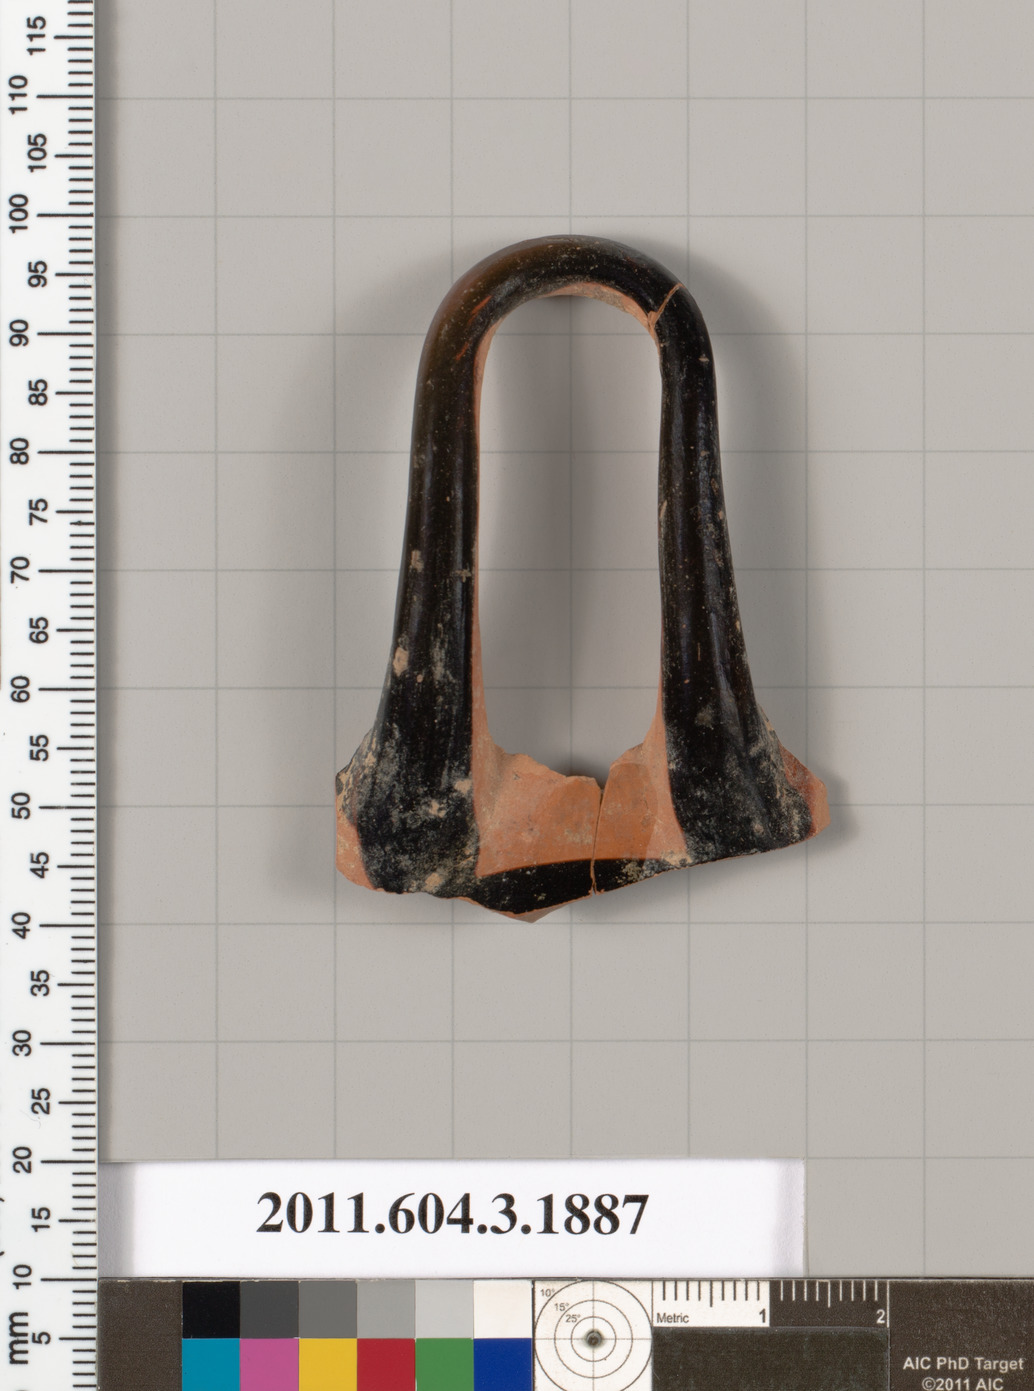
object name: kylix or skyphos fragment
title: Terracotta fragment of a kylix (drinking cup) or a skyphos (deep drinking cup)?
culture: greek, attic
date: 600-401 BCE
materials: terracotta